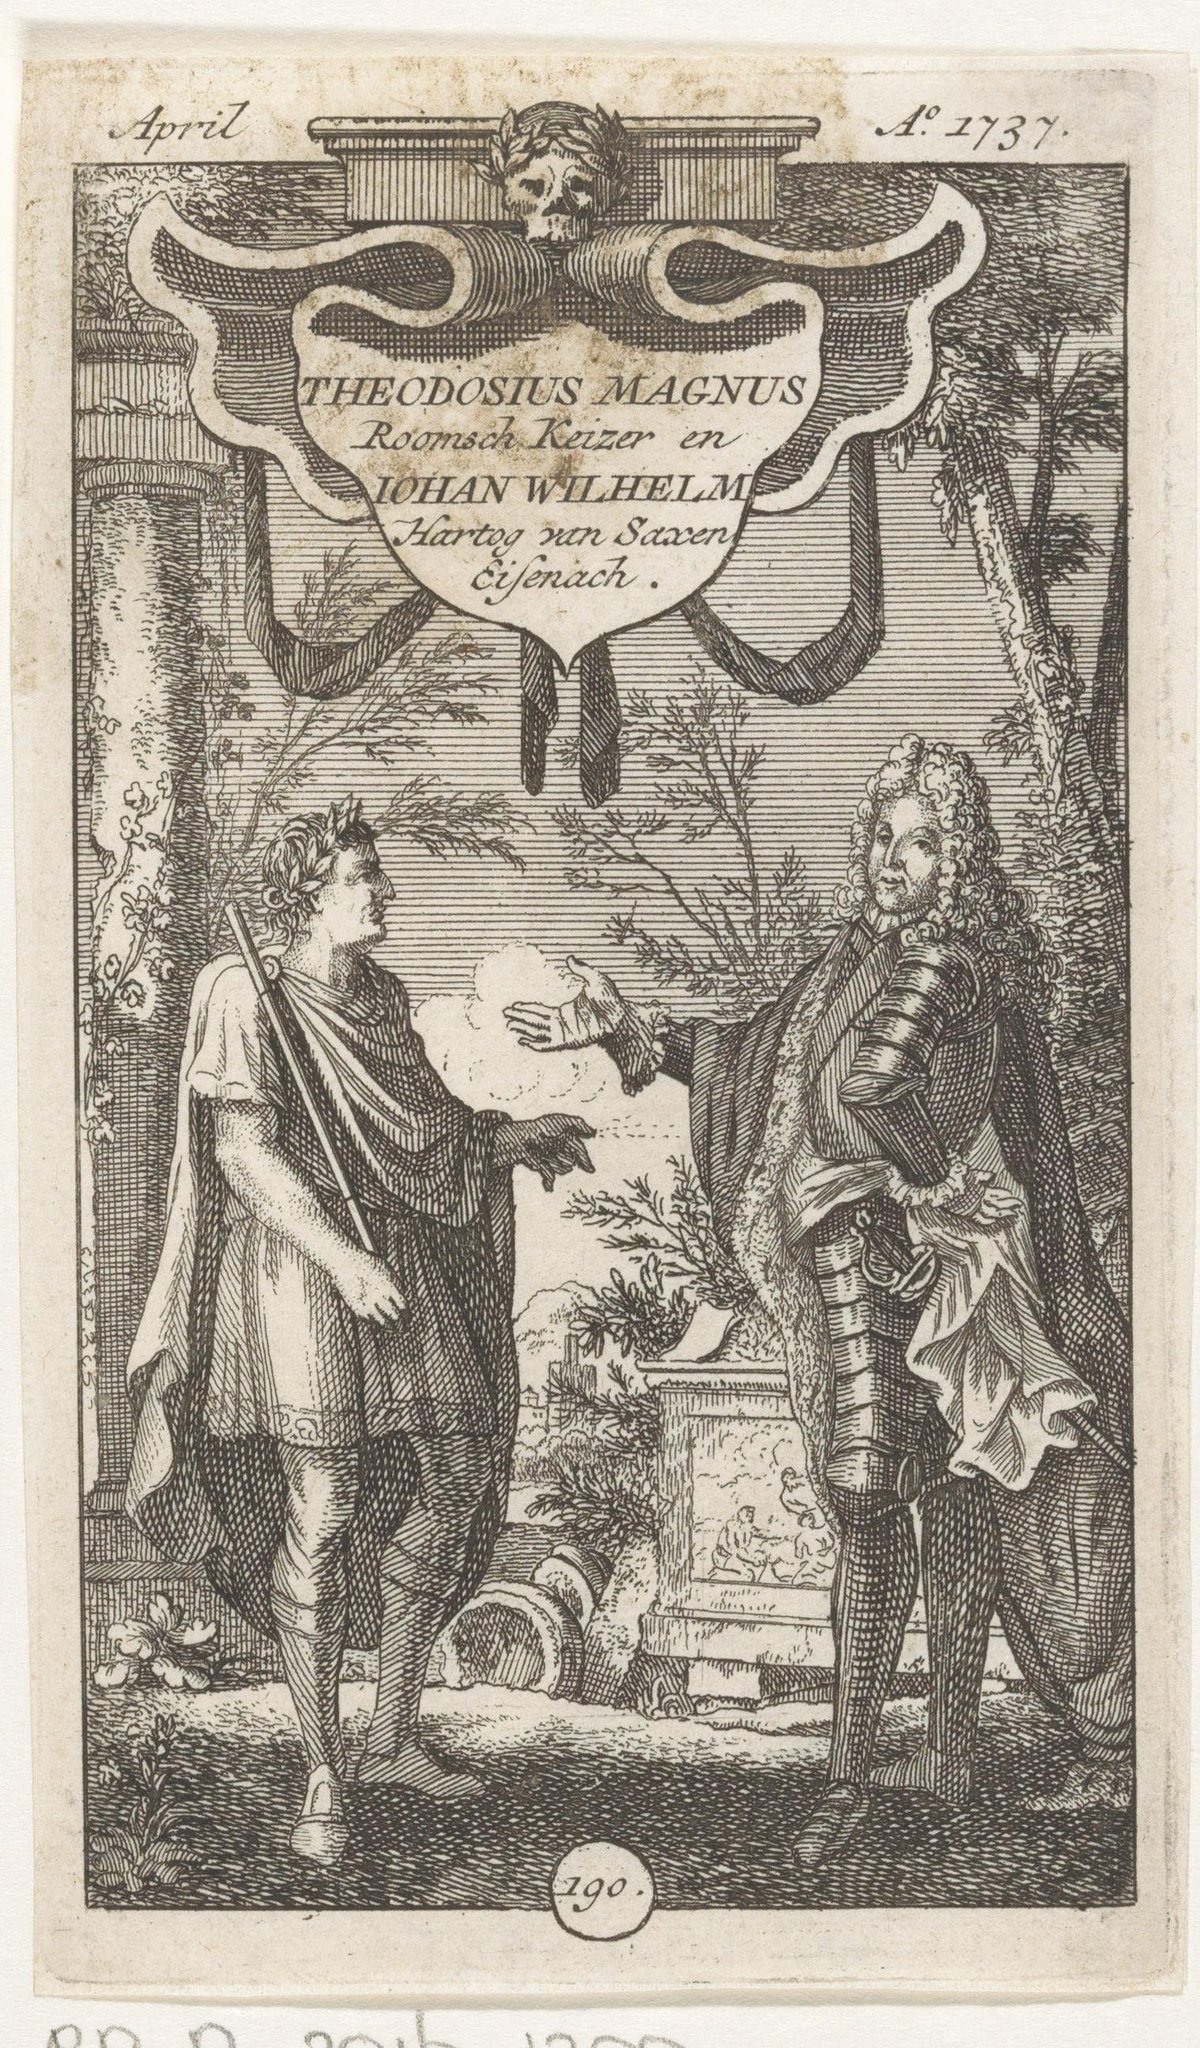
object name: book illustration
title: Gesprek tussen keizer Theodosius I en Johan Willem, hertog van Saksen-Eisenach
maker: Anonymous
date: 1704-1737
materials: paper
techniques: etching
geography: amsterdam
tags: landscape with ruins, conversation, dialogue; conversation piece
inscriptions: collector's mark: Lugt 2228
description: Prent uit het tijdschrift: S.n. Maandelyksche berichten uit de andere waerelt; of de spreekende dooden. Amsterdam: Ratelband, erven Johannes, april 1737. Prent afkomstig uit een plakalbum met titelprenten, ornamenten etc. op blauw papier in 1983 uit elkaar gehaald.